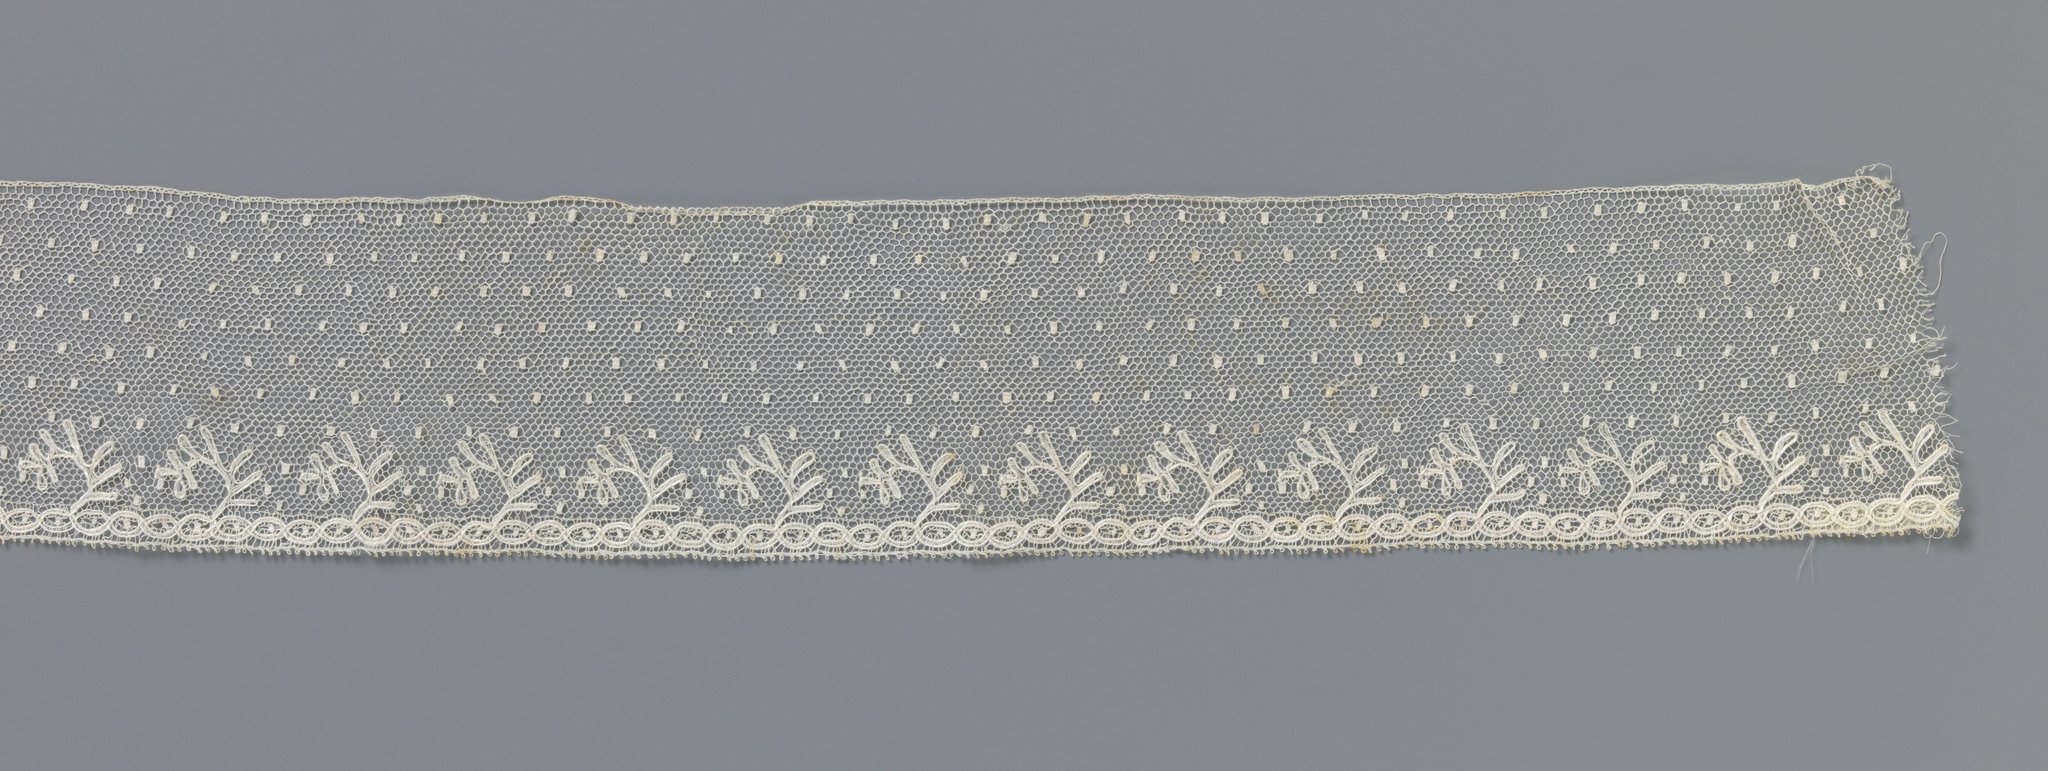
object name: strip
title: Strook kloskant met eenzijdig gerichte takjes met stijve rechte blaadjes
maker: Anonymous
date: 1805-1815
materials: linen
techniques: lace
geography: lille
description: Strook naturelkleurige kloskant: Rijselse kant. Onder een breed strooipatroon van vierkante moesjes bestaat het zich herhalende patroon uit een krom takje met stijve rechte blaadjes. Het takje ontspringt aan een rij aaneengeschakelde ovaaltjes langs de onderzijde van de strook. De motieven zijn met elkaar verbonden door een fijne traliegrond, een tulegrond. Het spaarzame volwerk is gemaakt in linnenslag, met dikkere en glimmende contourdraden. De moesjes zijn gemaakt in vormslag. De boven- en onderzijde van de strook zijn recht afgewerkt, waarbij de onderzijde is voorzien van picots.